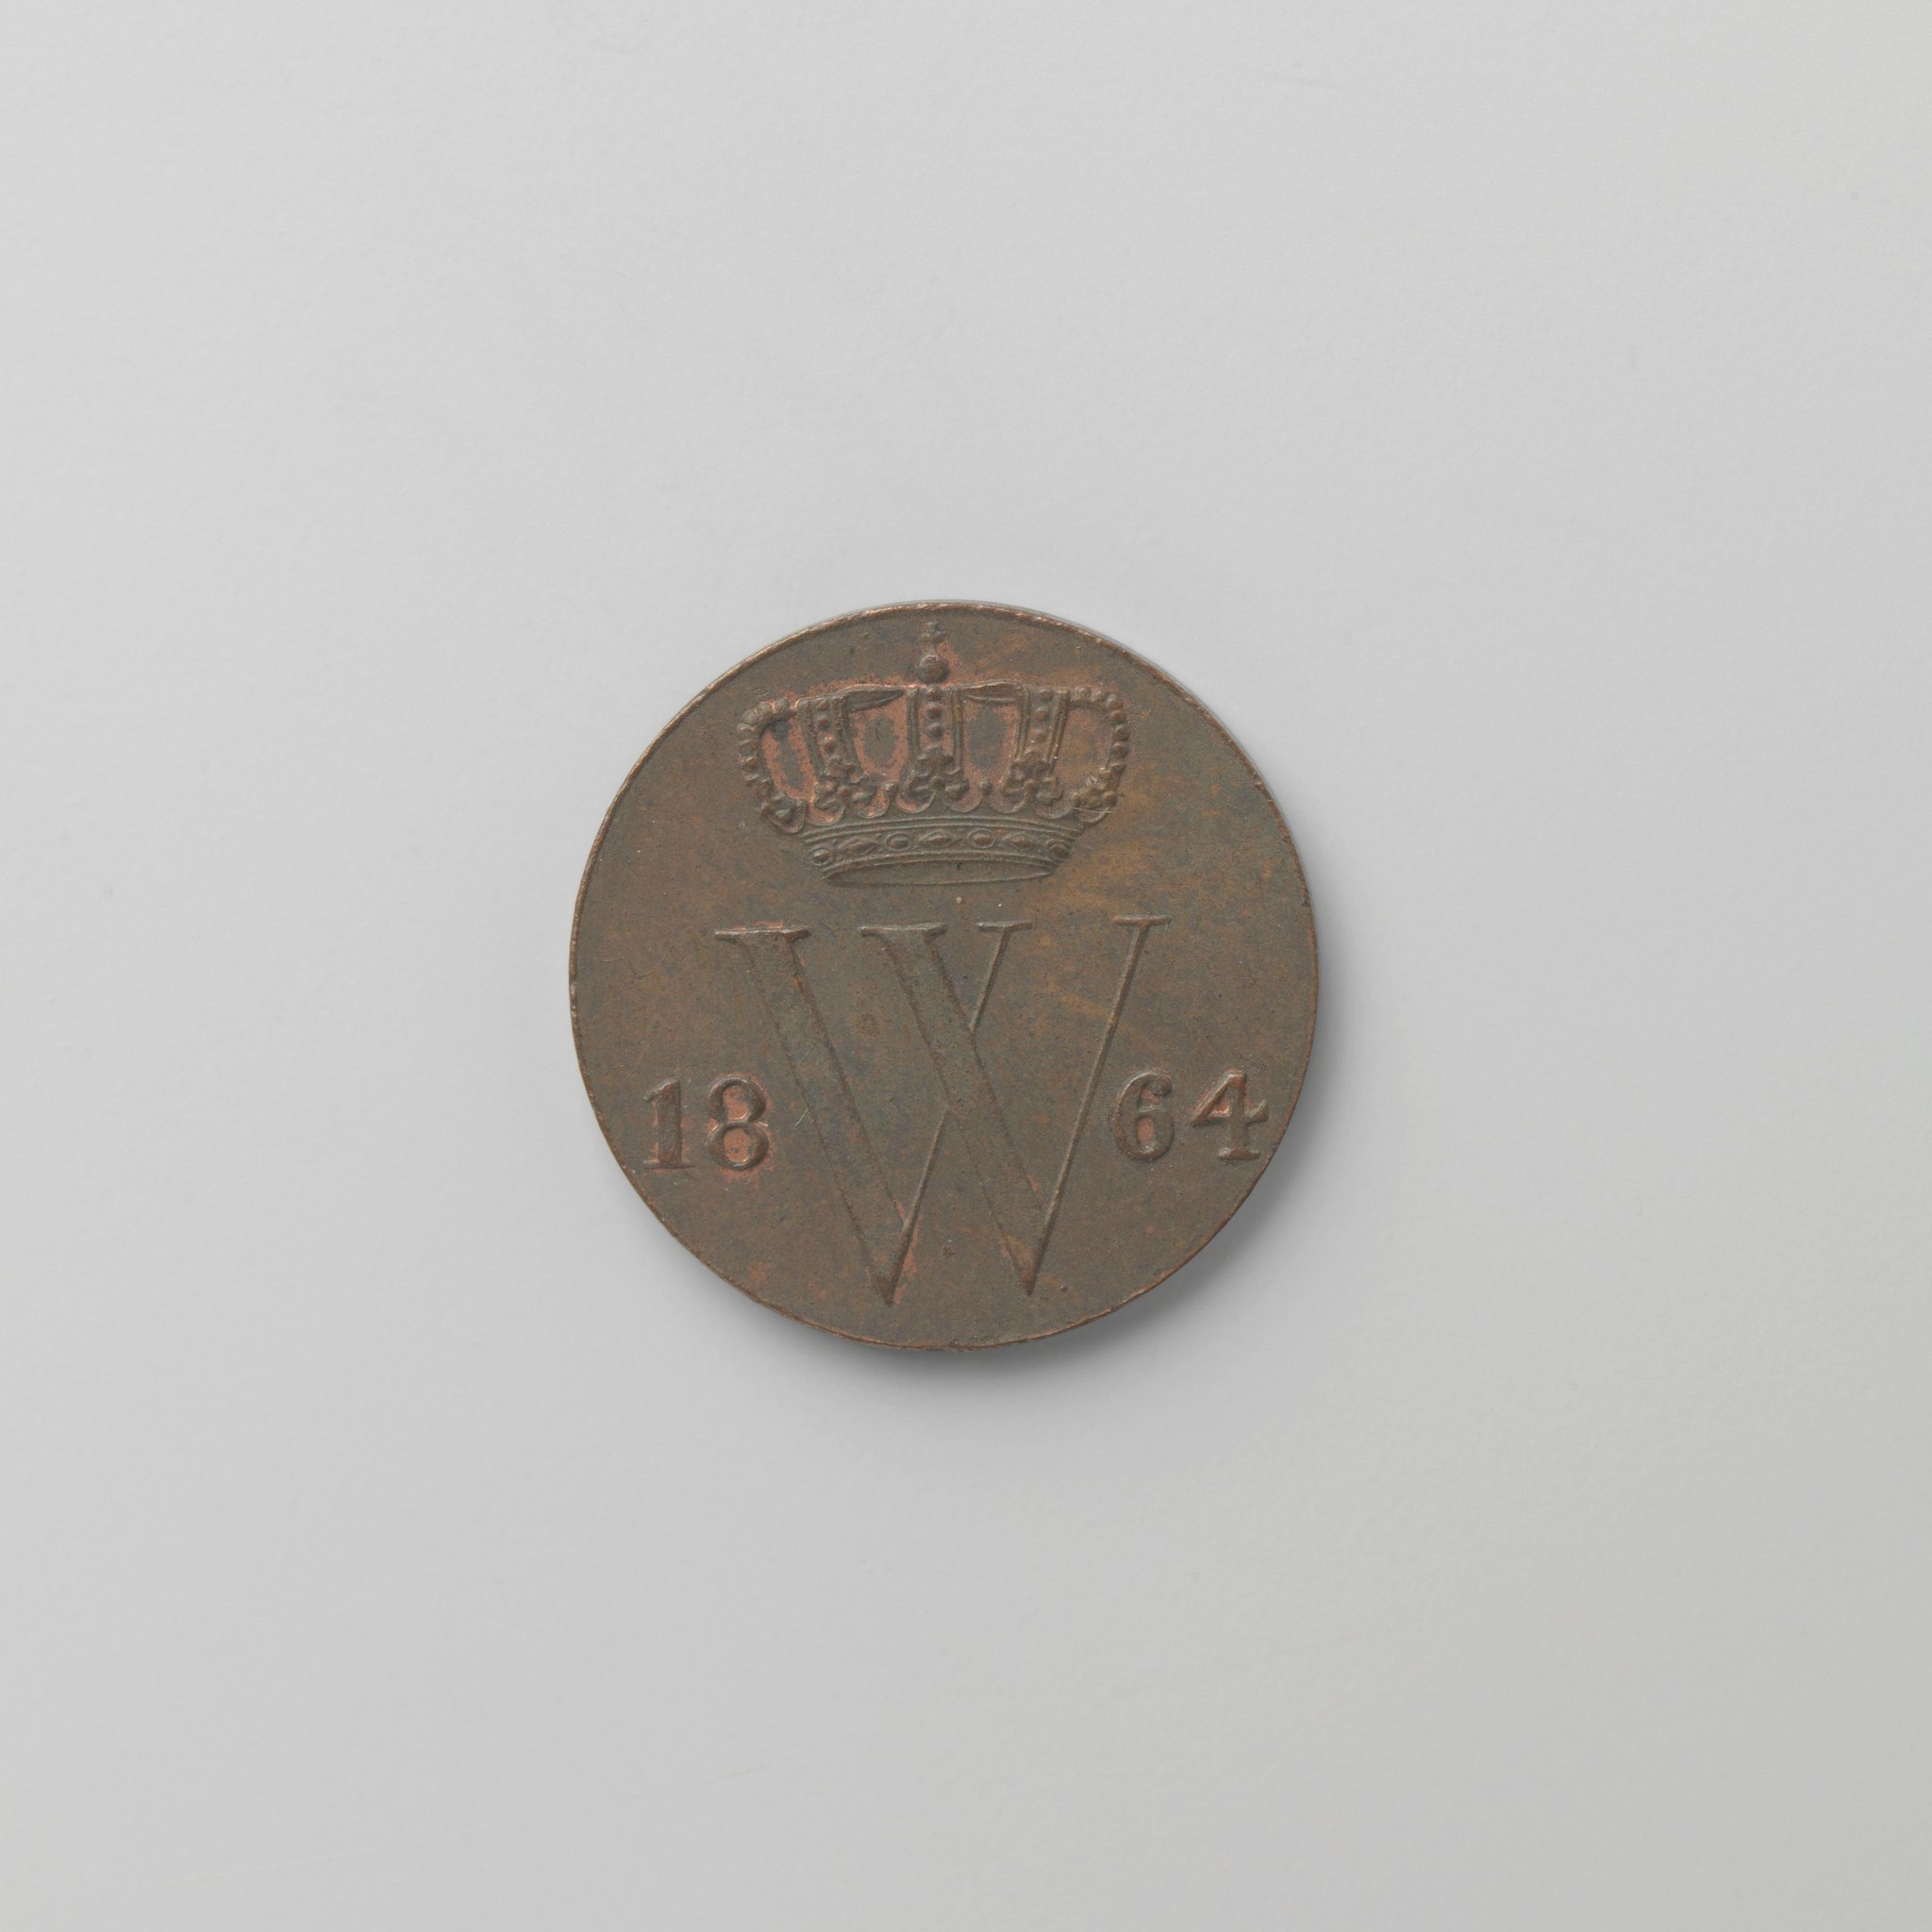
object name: coin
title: Nederland, ½ cent, 1864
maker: willem iii (koning der nederlanden)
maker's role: koning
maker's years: 1817-1890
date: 1864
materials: copper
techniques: striking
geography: utrecht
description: Koperen munt. Voorzijde: tussen jaartal gekroonde rechte letter W. Keerzijde: tussen waarde-aanduiding ½ C. gekroond rijkswapenschild. Gladde rand.